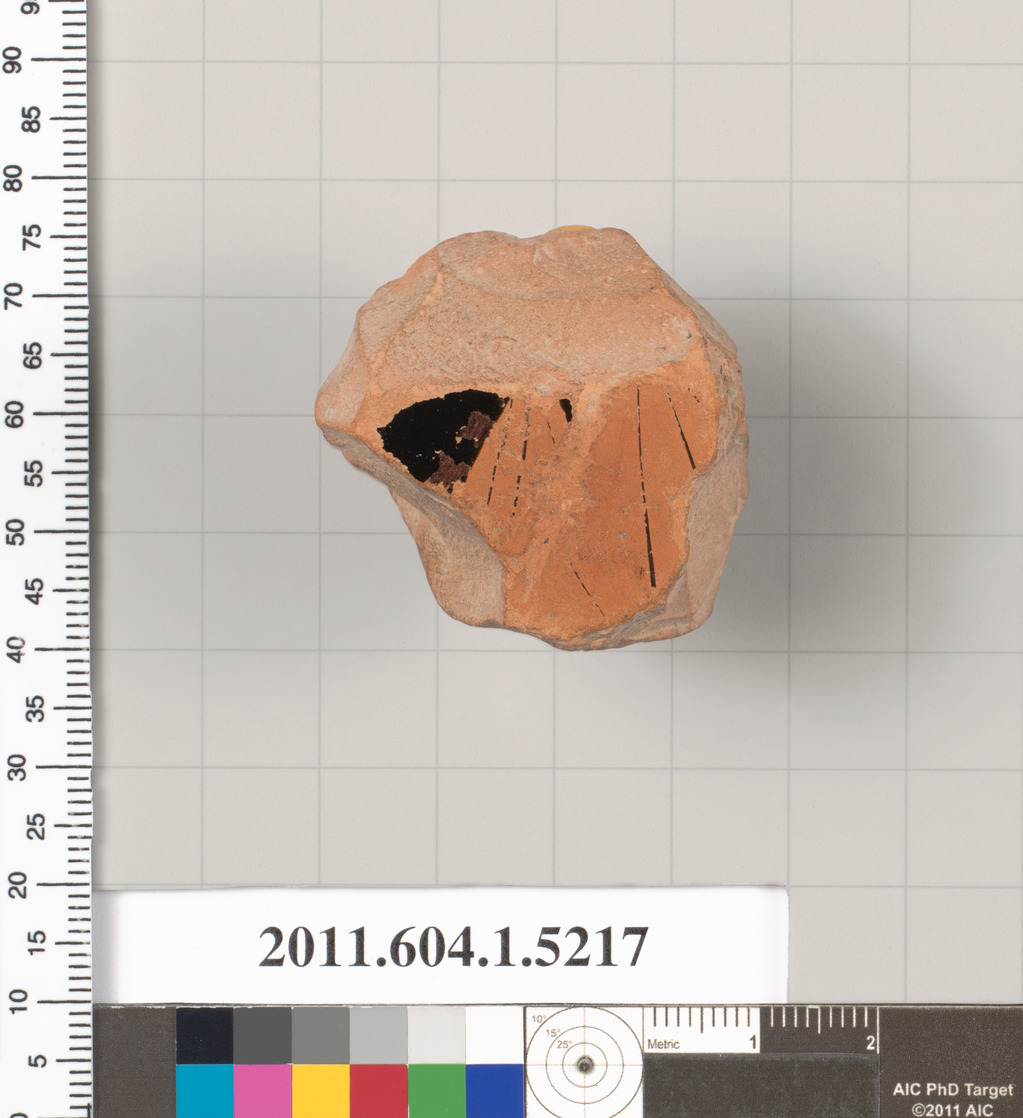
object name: kylix fragment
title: Terracotta fragment of a kylix (drinking cup)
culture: greek, attic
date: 475-451 BCE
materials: terracotta